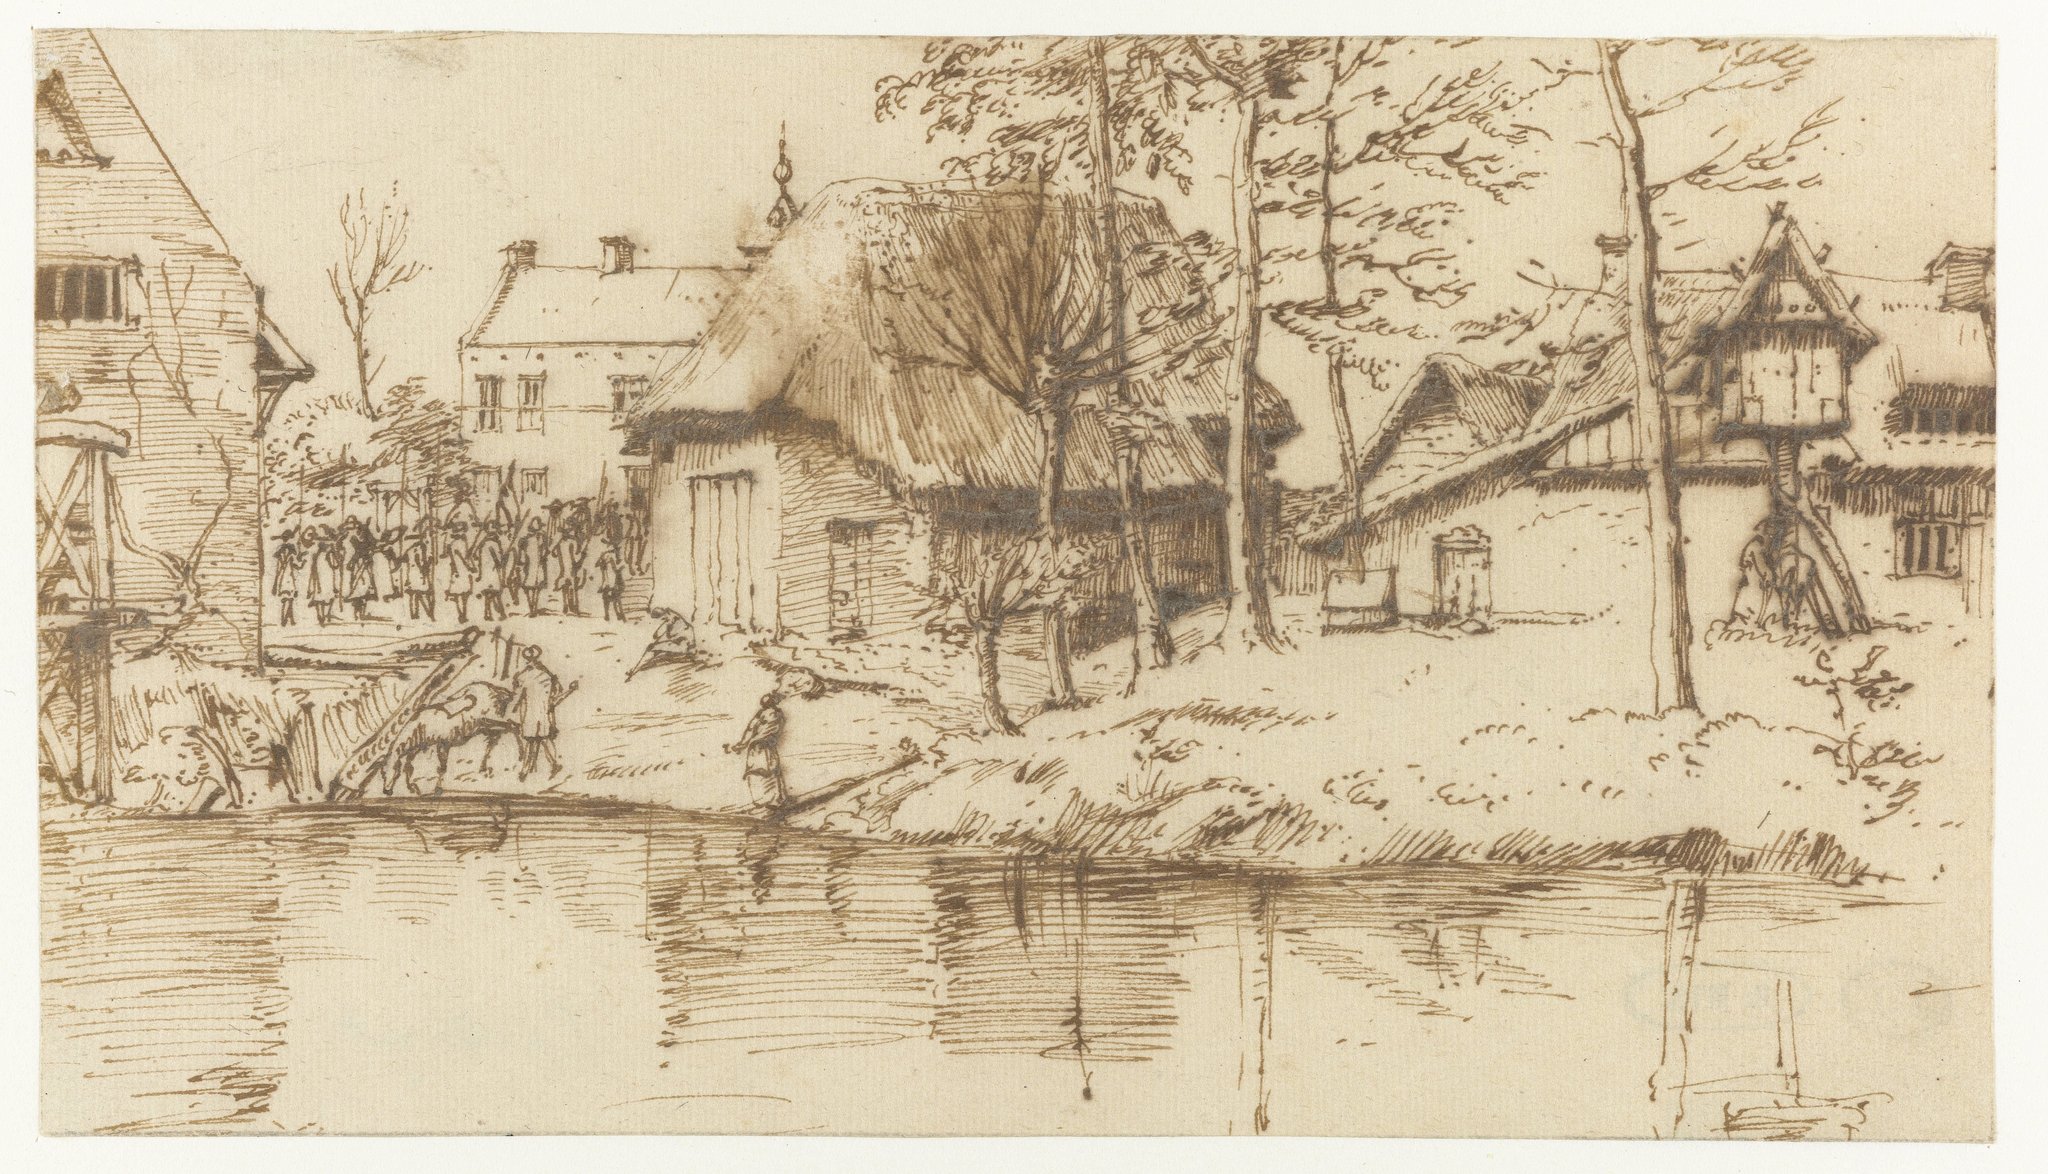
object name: drawing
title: Kestergat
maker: constantijn huygens (ii)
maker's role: draughtsman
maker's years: 1628-1697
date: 1676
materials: ink, paper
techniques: pen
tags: prospect of village, silhouette of village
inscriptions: date: ‘25 apr. 1676’